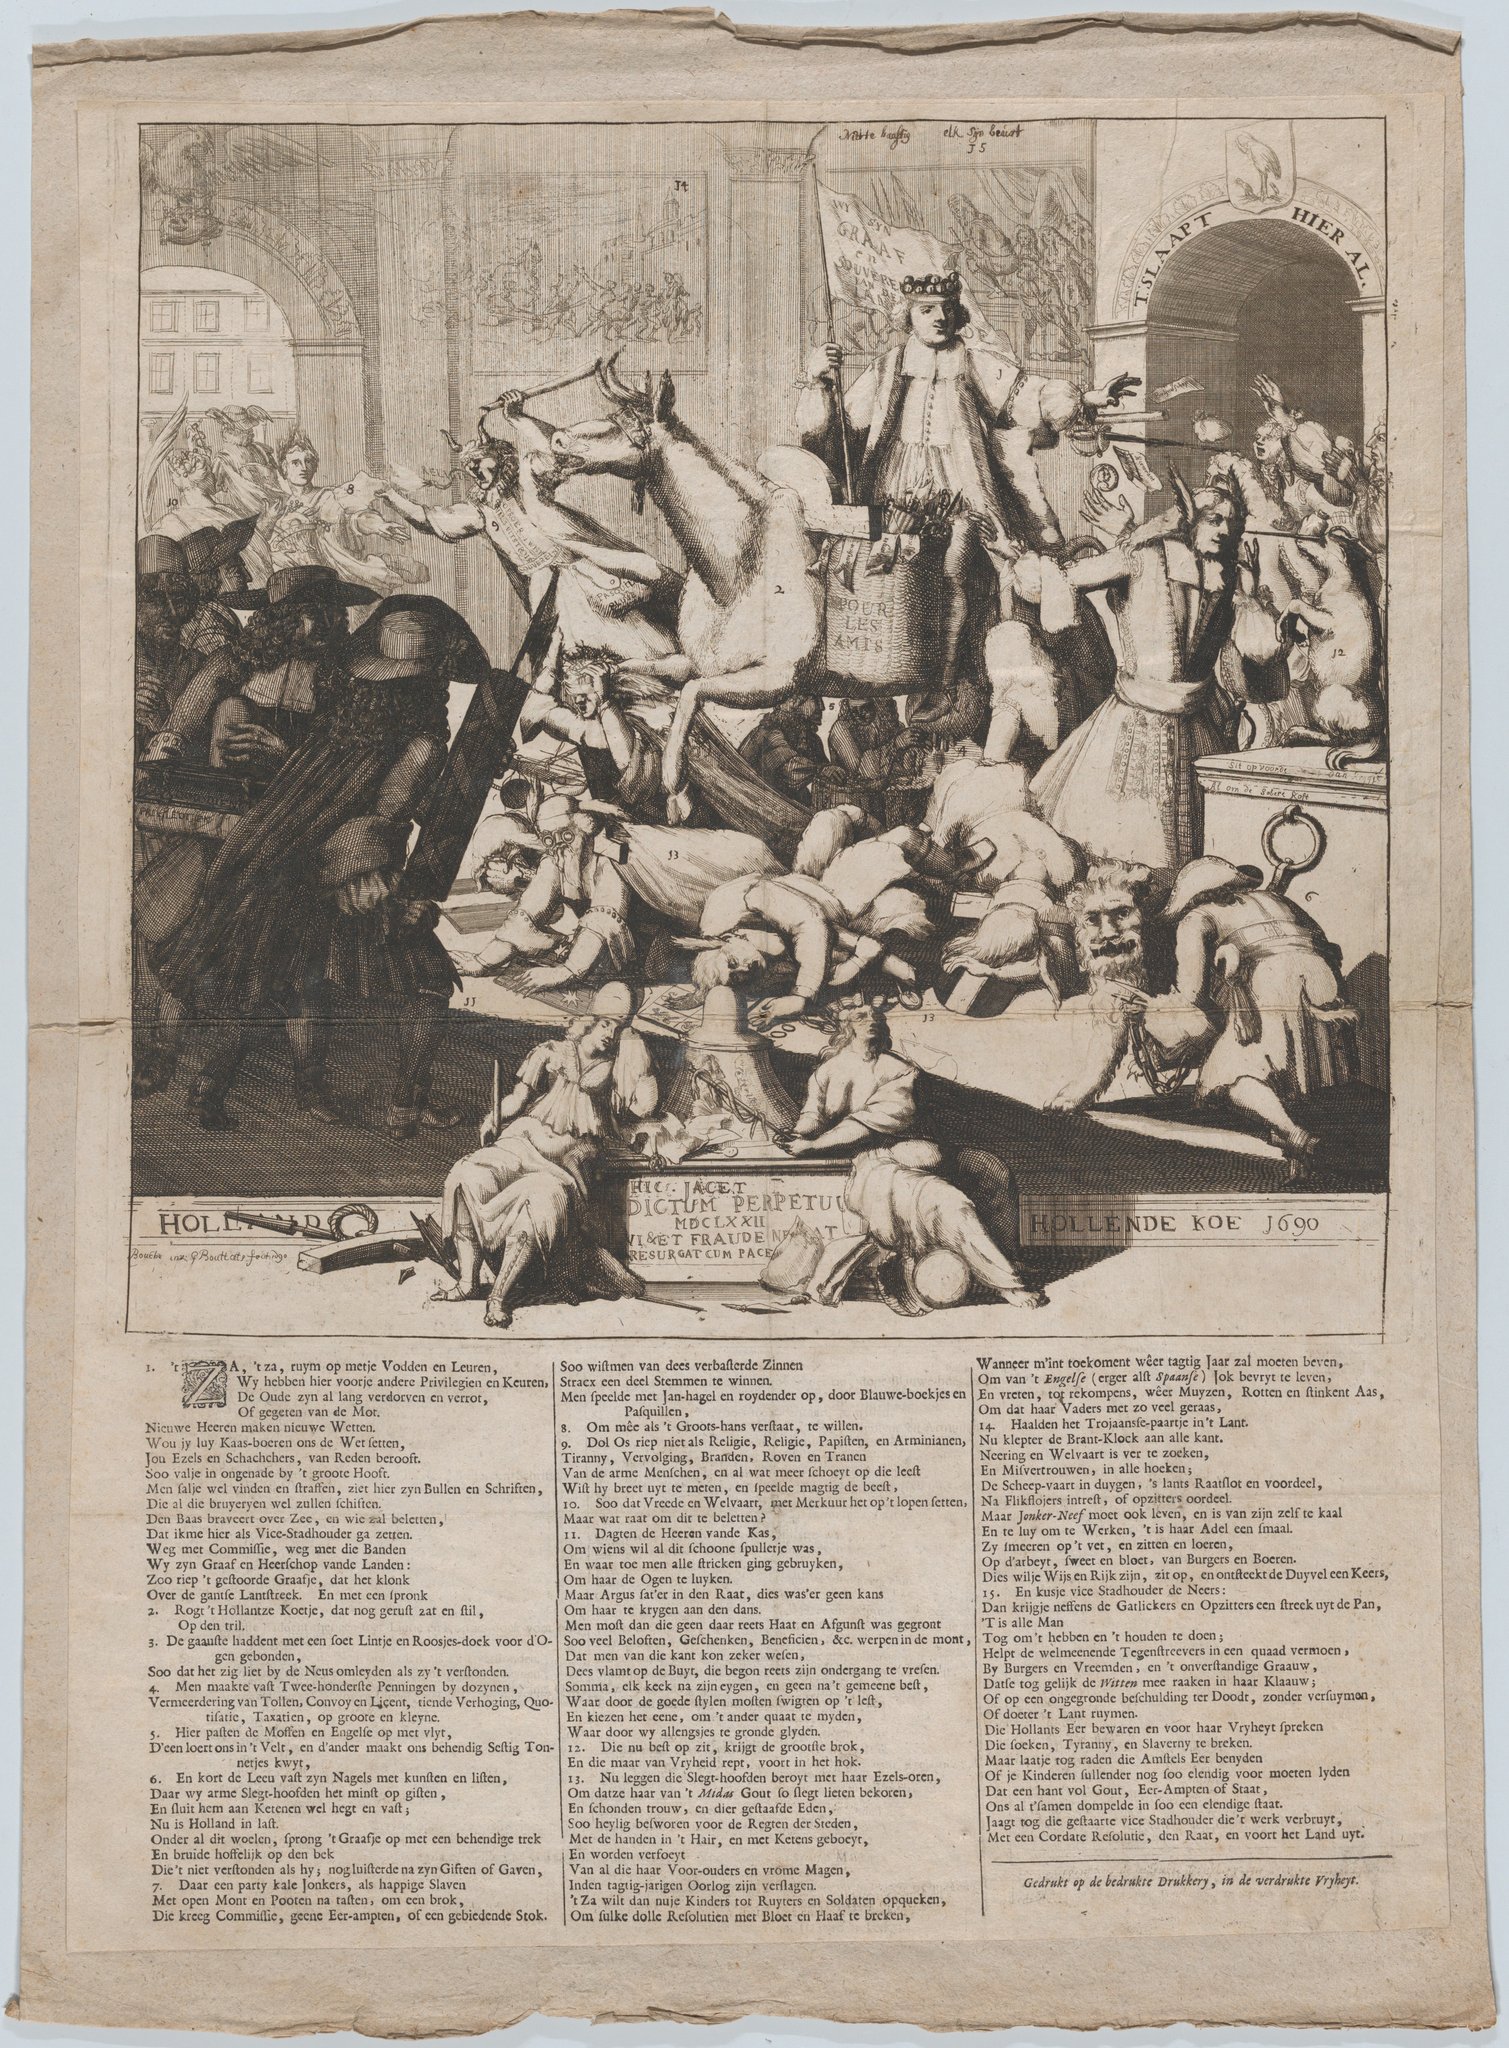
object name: print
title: Hollands Hollende Koe (Holland’s Running Cow)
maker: gaspar bouttats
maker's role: artist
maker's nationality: dutch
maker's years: 1648-1695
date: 1690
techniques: etching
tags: men,cows